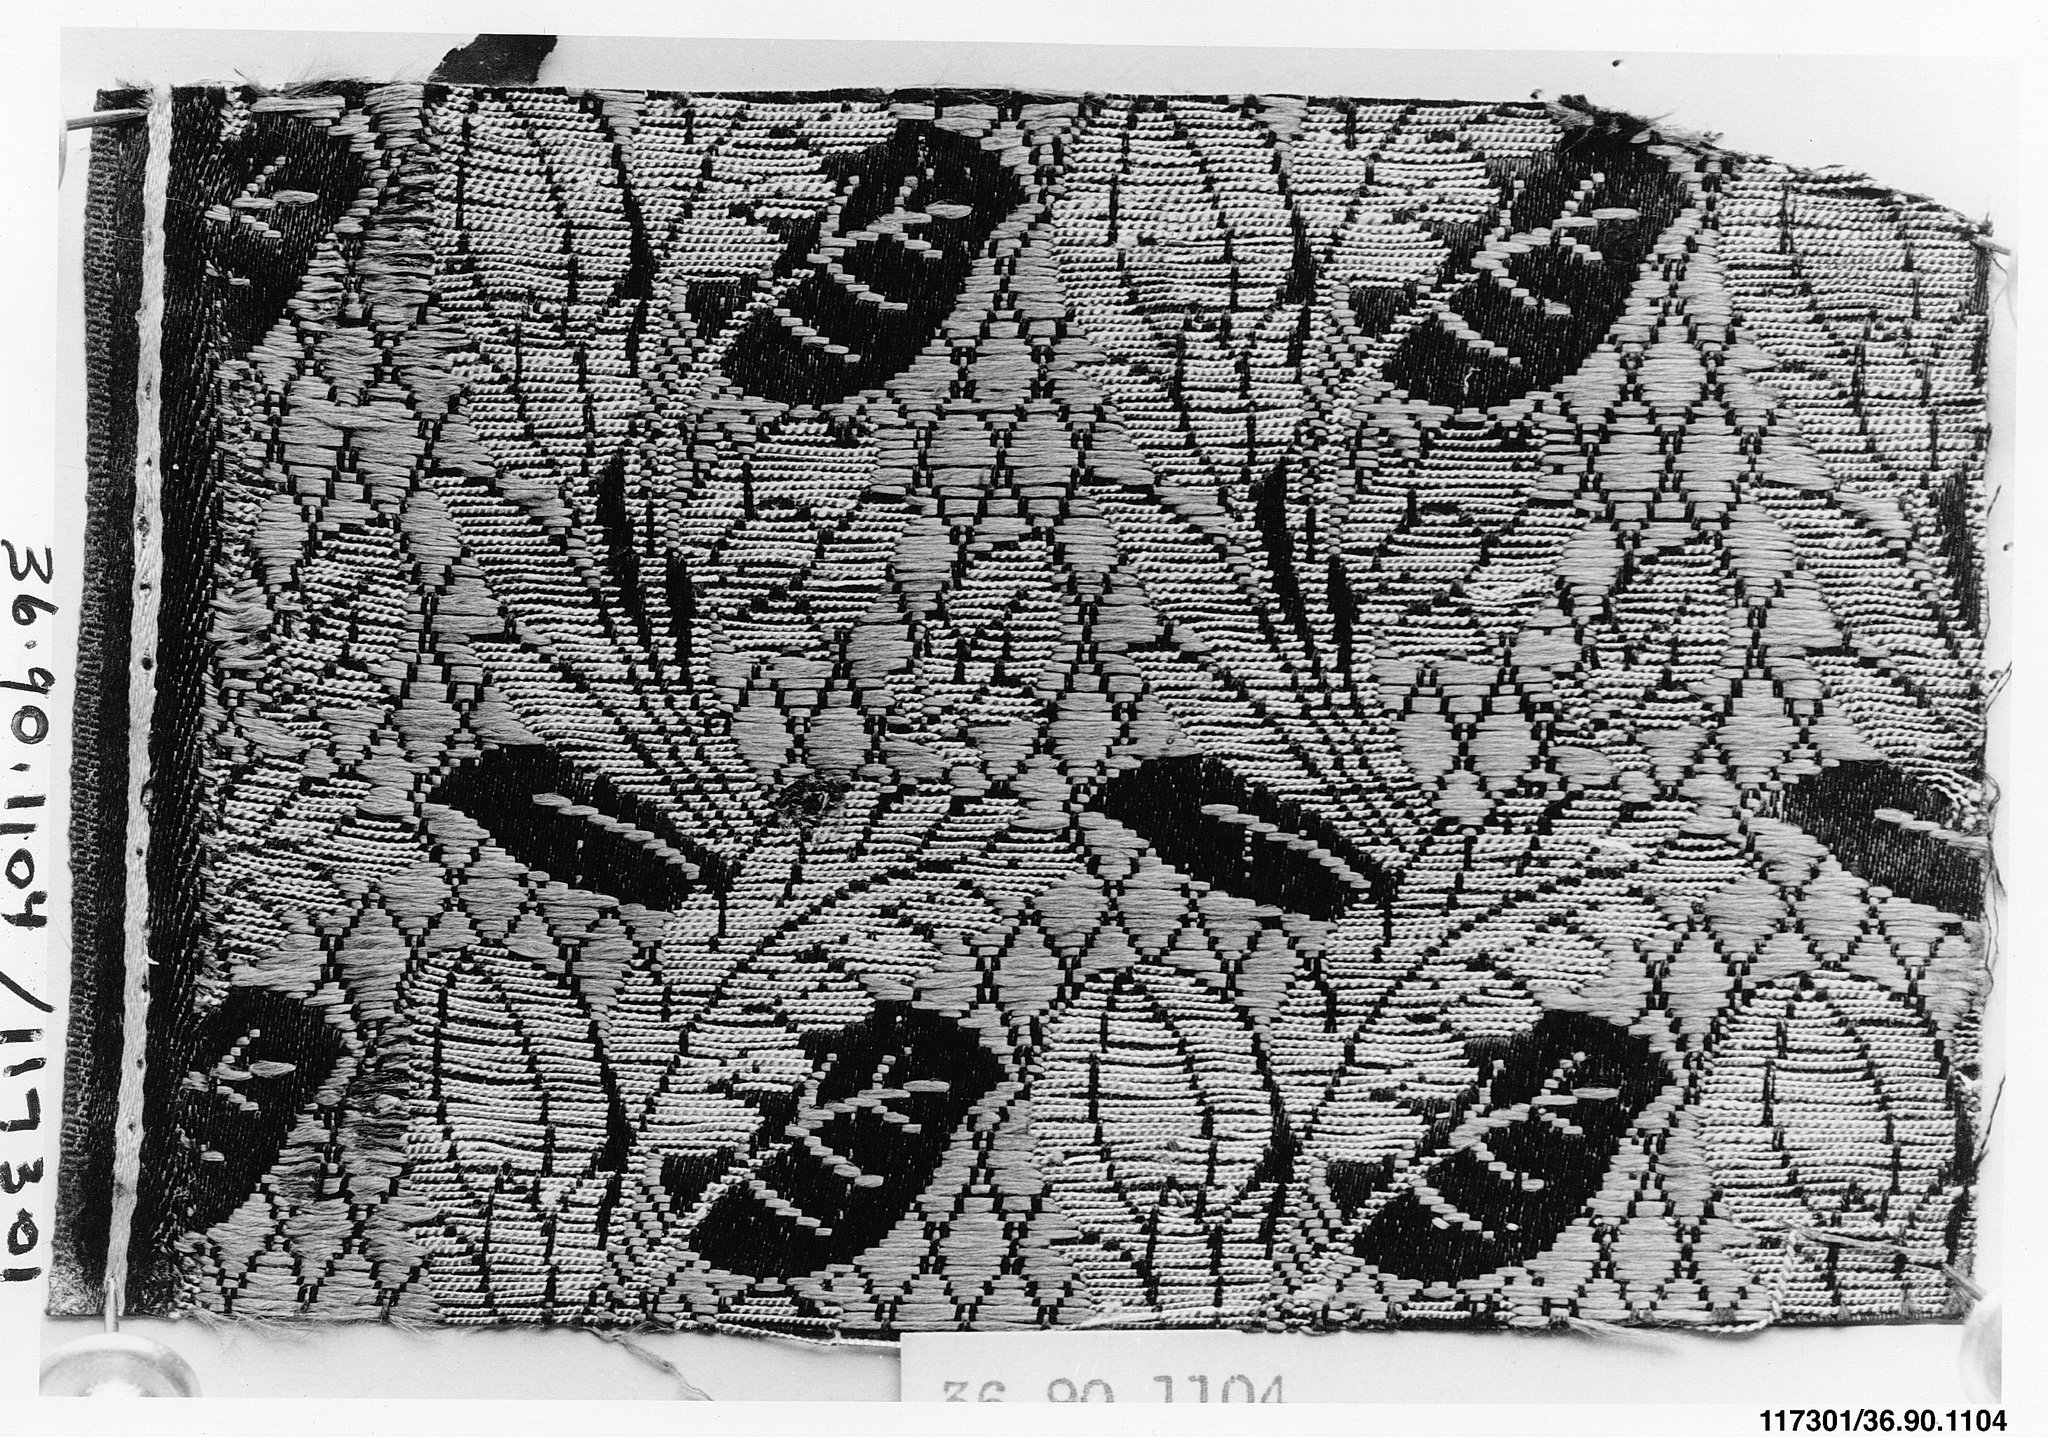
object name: sample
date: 1701-1900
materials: metal thread, silk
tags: leaves